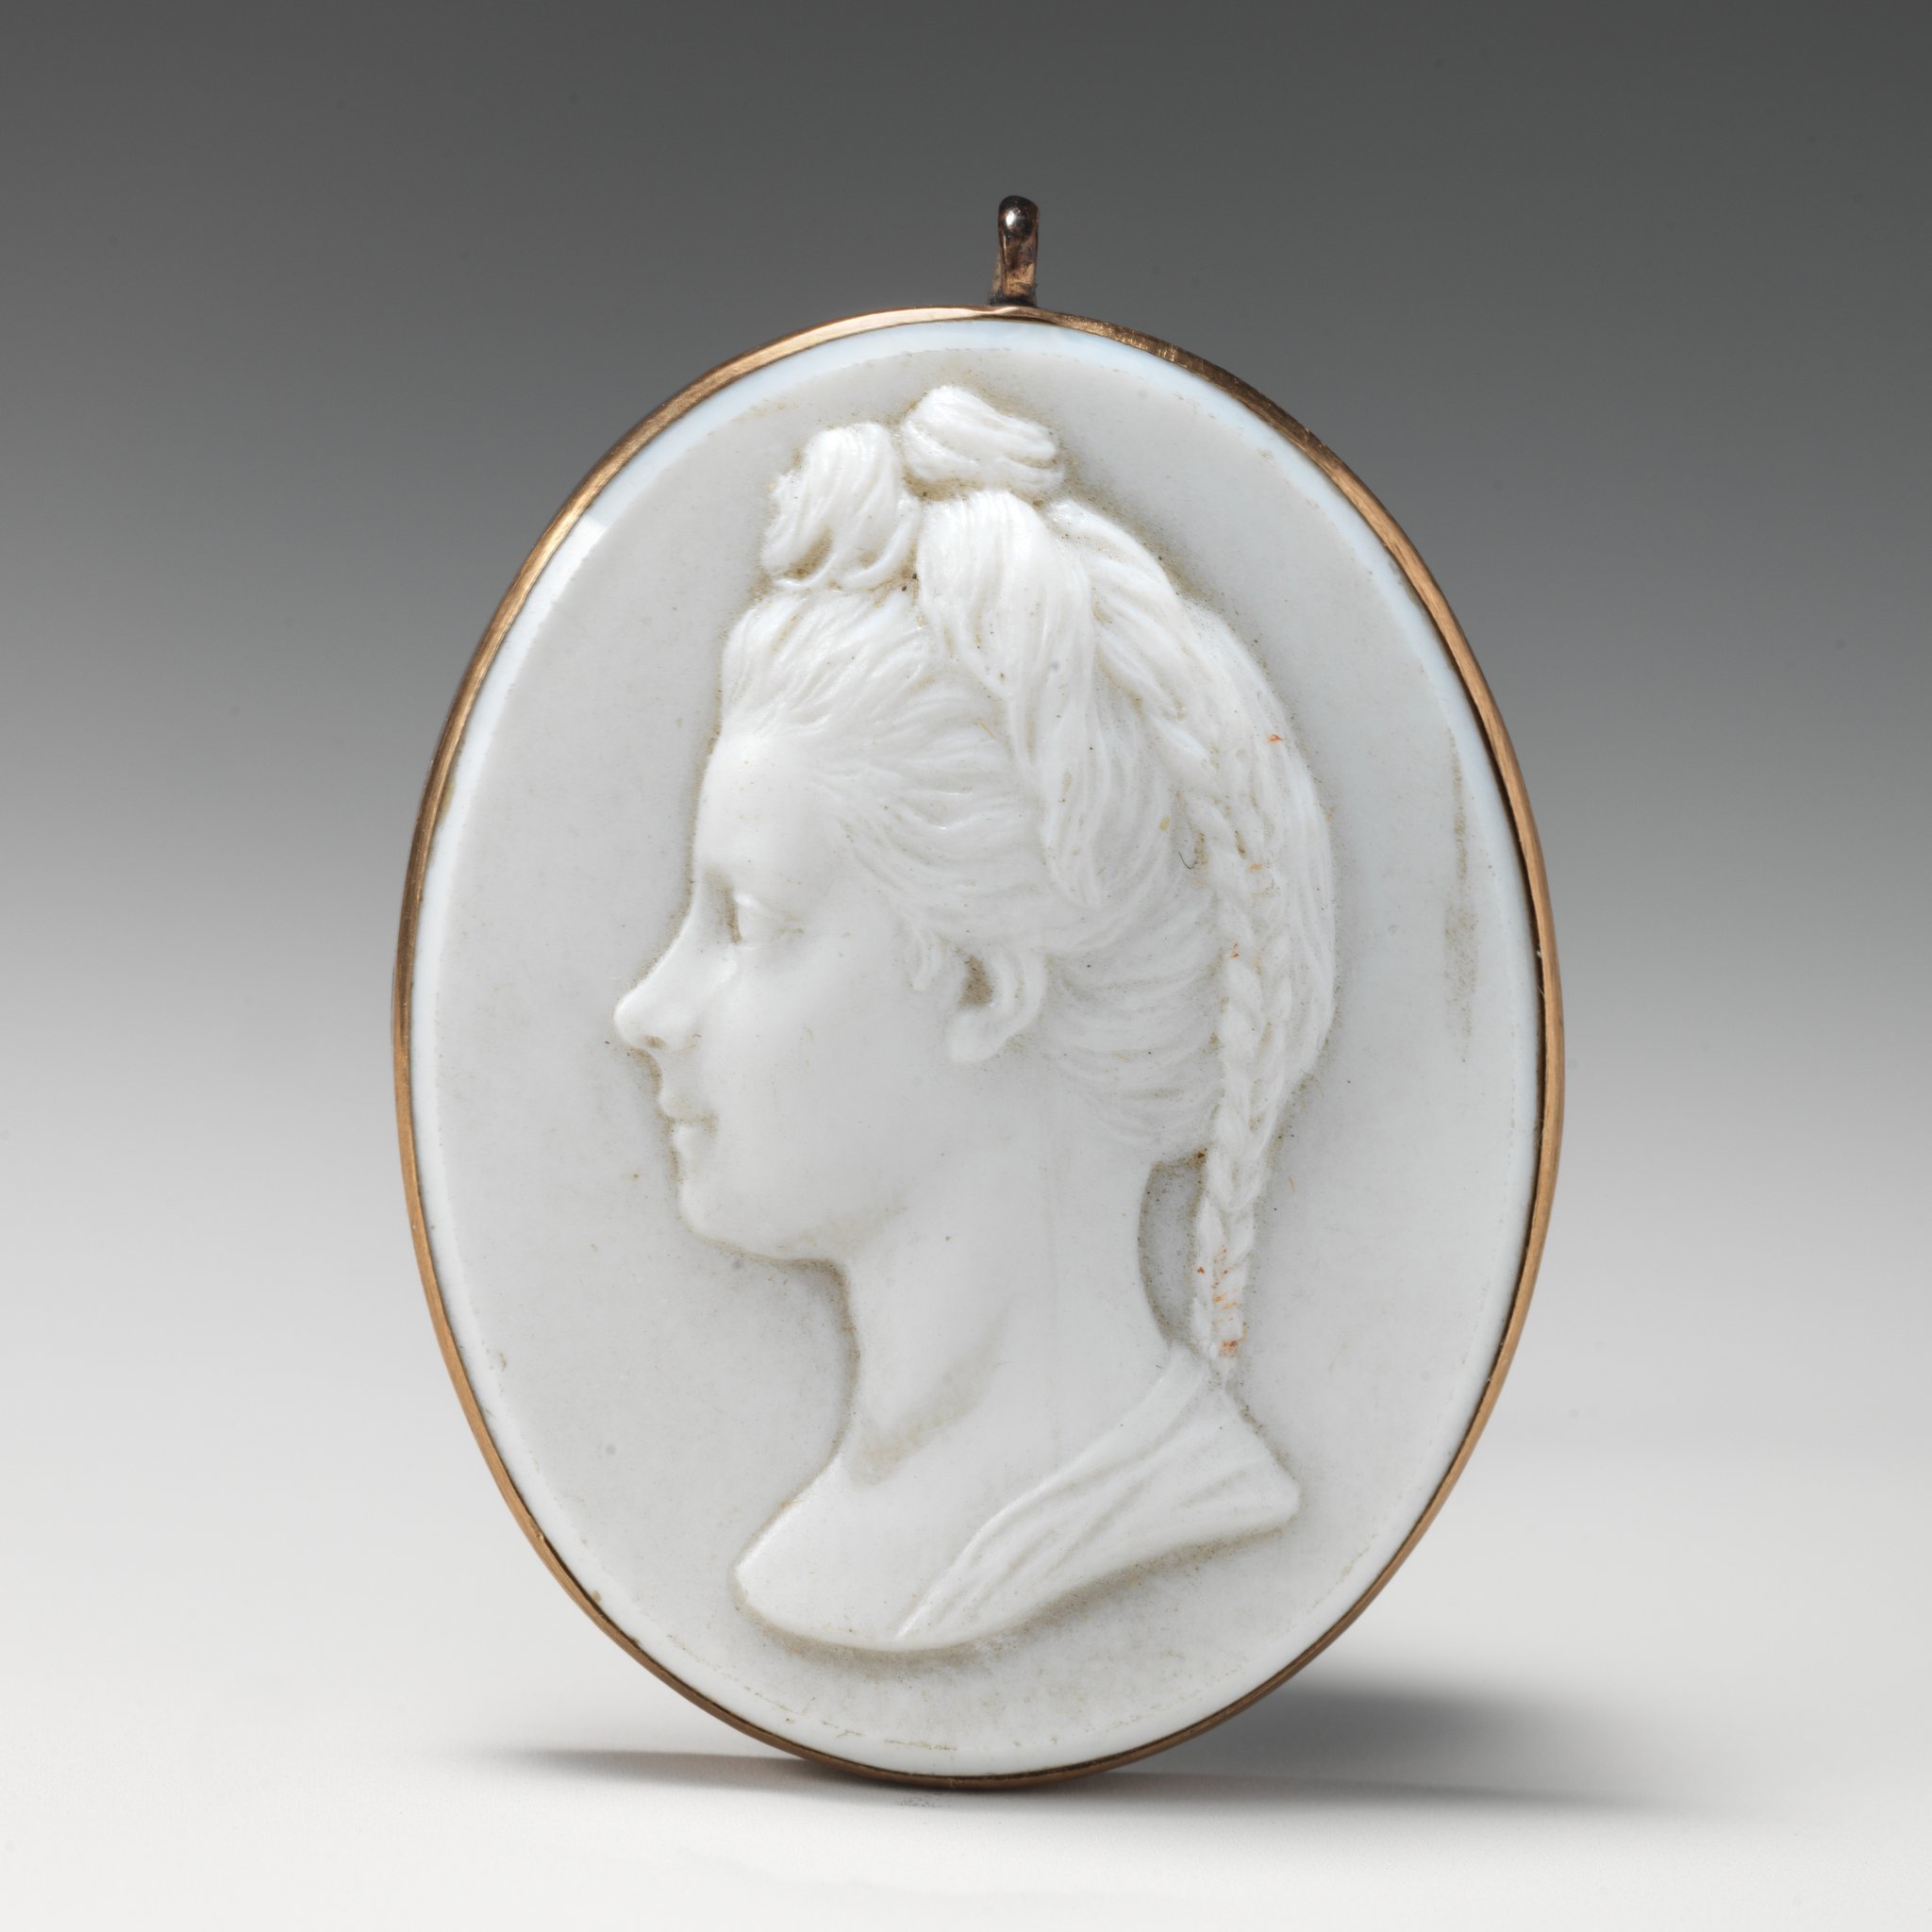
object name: medallion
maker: james tassie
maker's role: artist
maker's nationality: british, scottish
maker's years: 1735-1799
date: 1701-1800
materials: glass, paste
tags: profiles,women